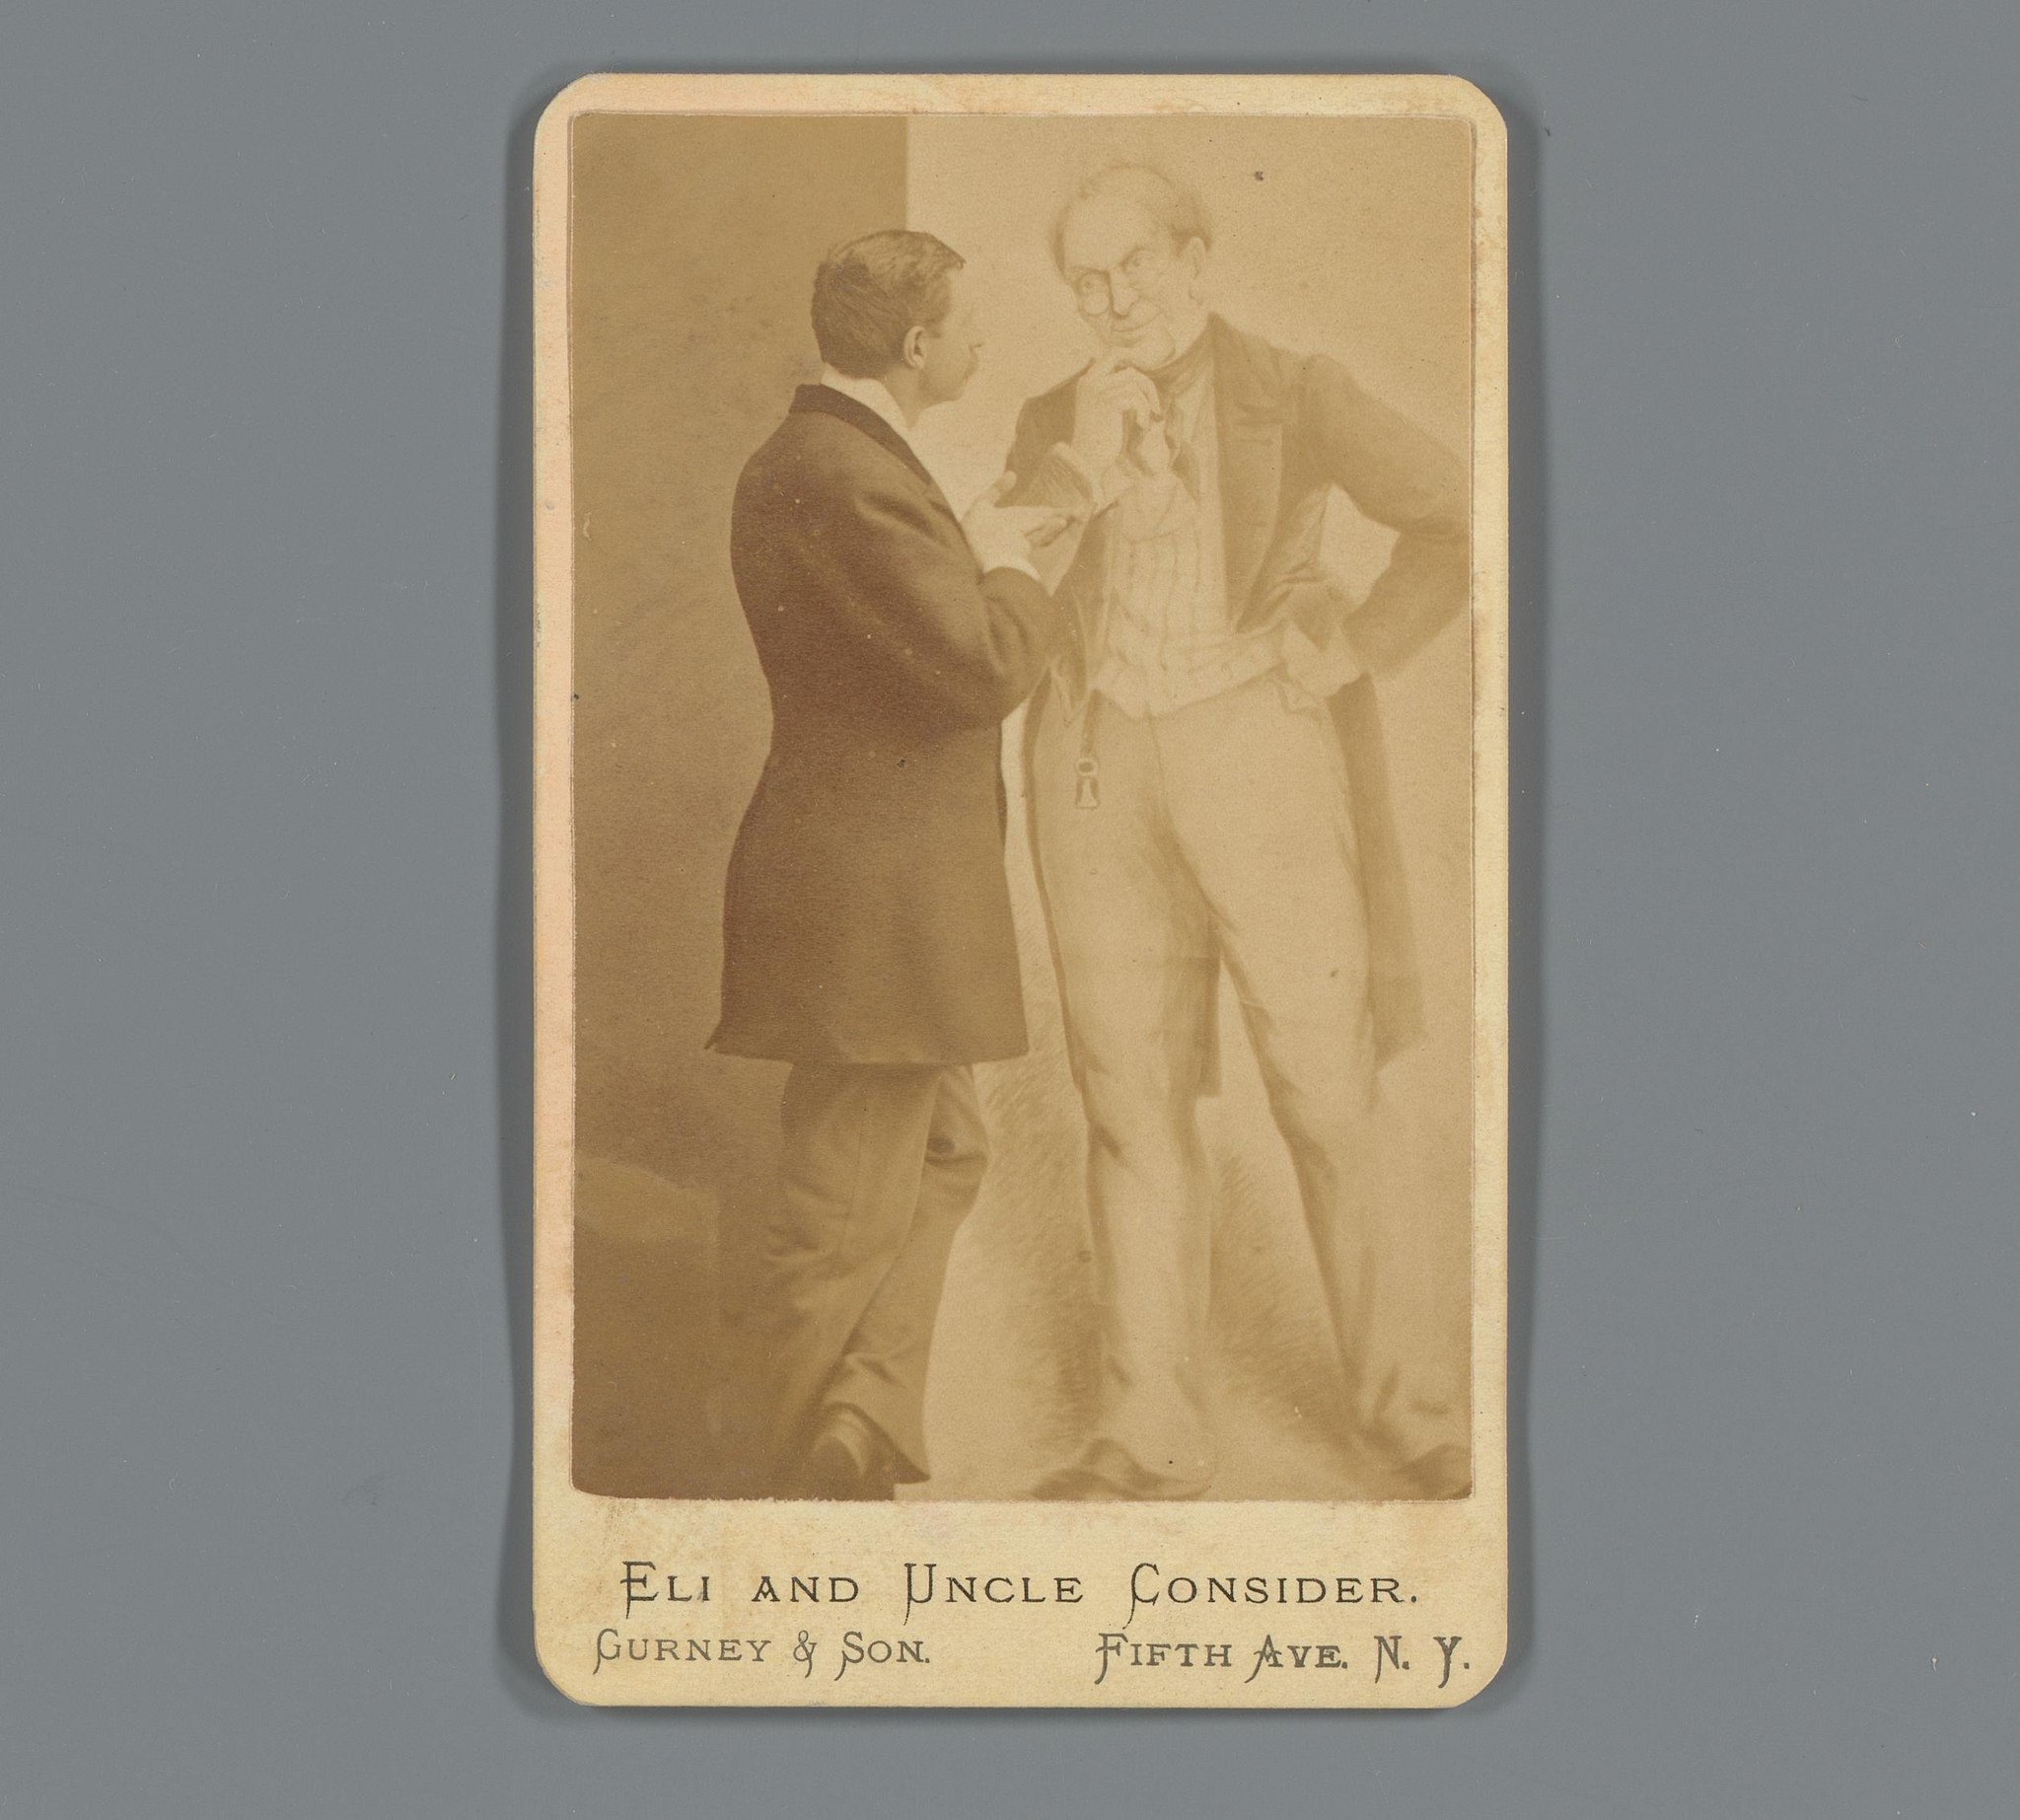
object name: carte de visite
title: Eli and uncle consider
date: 1850-1915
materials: cardboard, photographic support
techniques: albumen print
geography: new york city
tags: advertising, journalist, reporter, historical persons, native peoples of the americas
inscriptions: inscription: ‘Gurrey & son. Fifth Ave. N.Y.’, inscription: ‘ELI PERKINS'/ "DEFENCE OF THE HEATHEN."/ ILLUSTRATED BY NAST AND WORTH.’